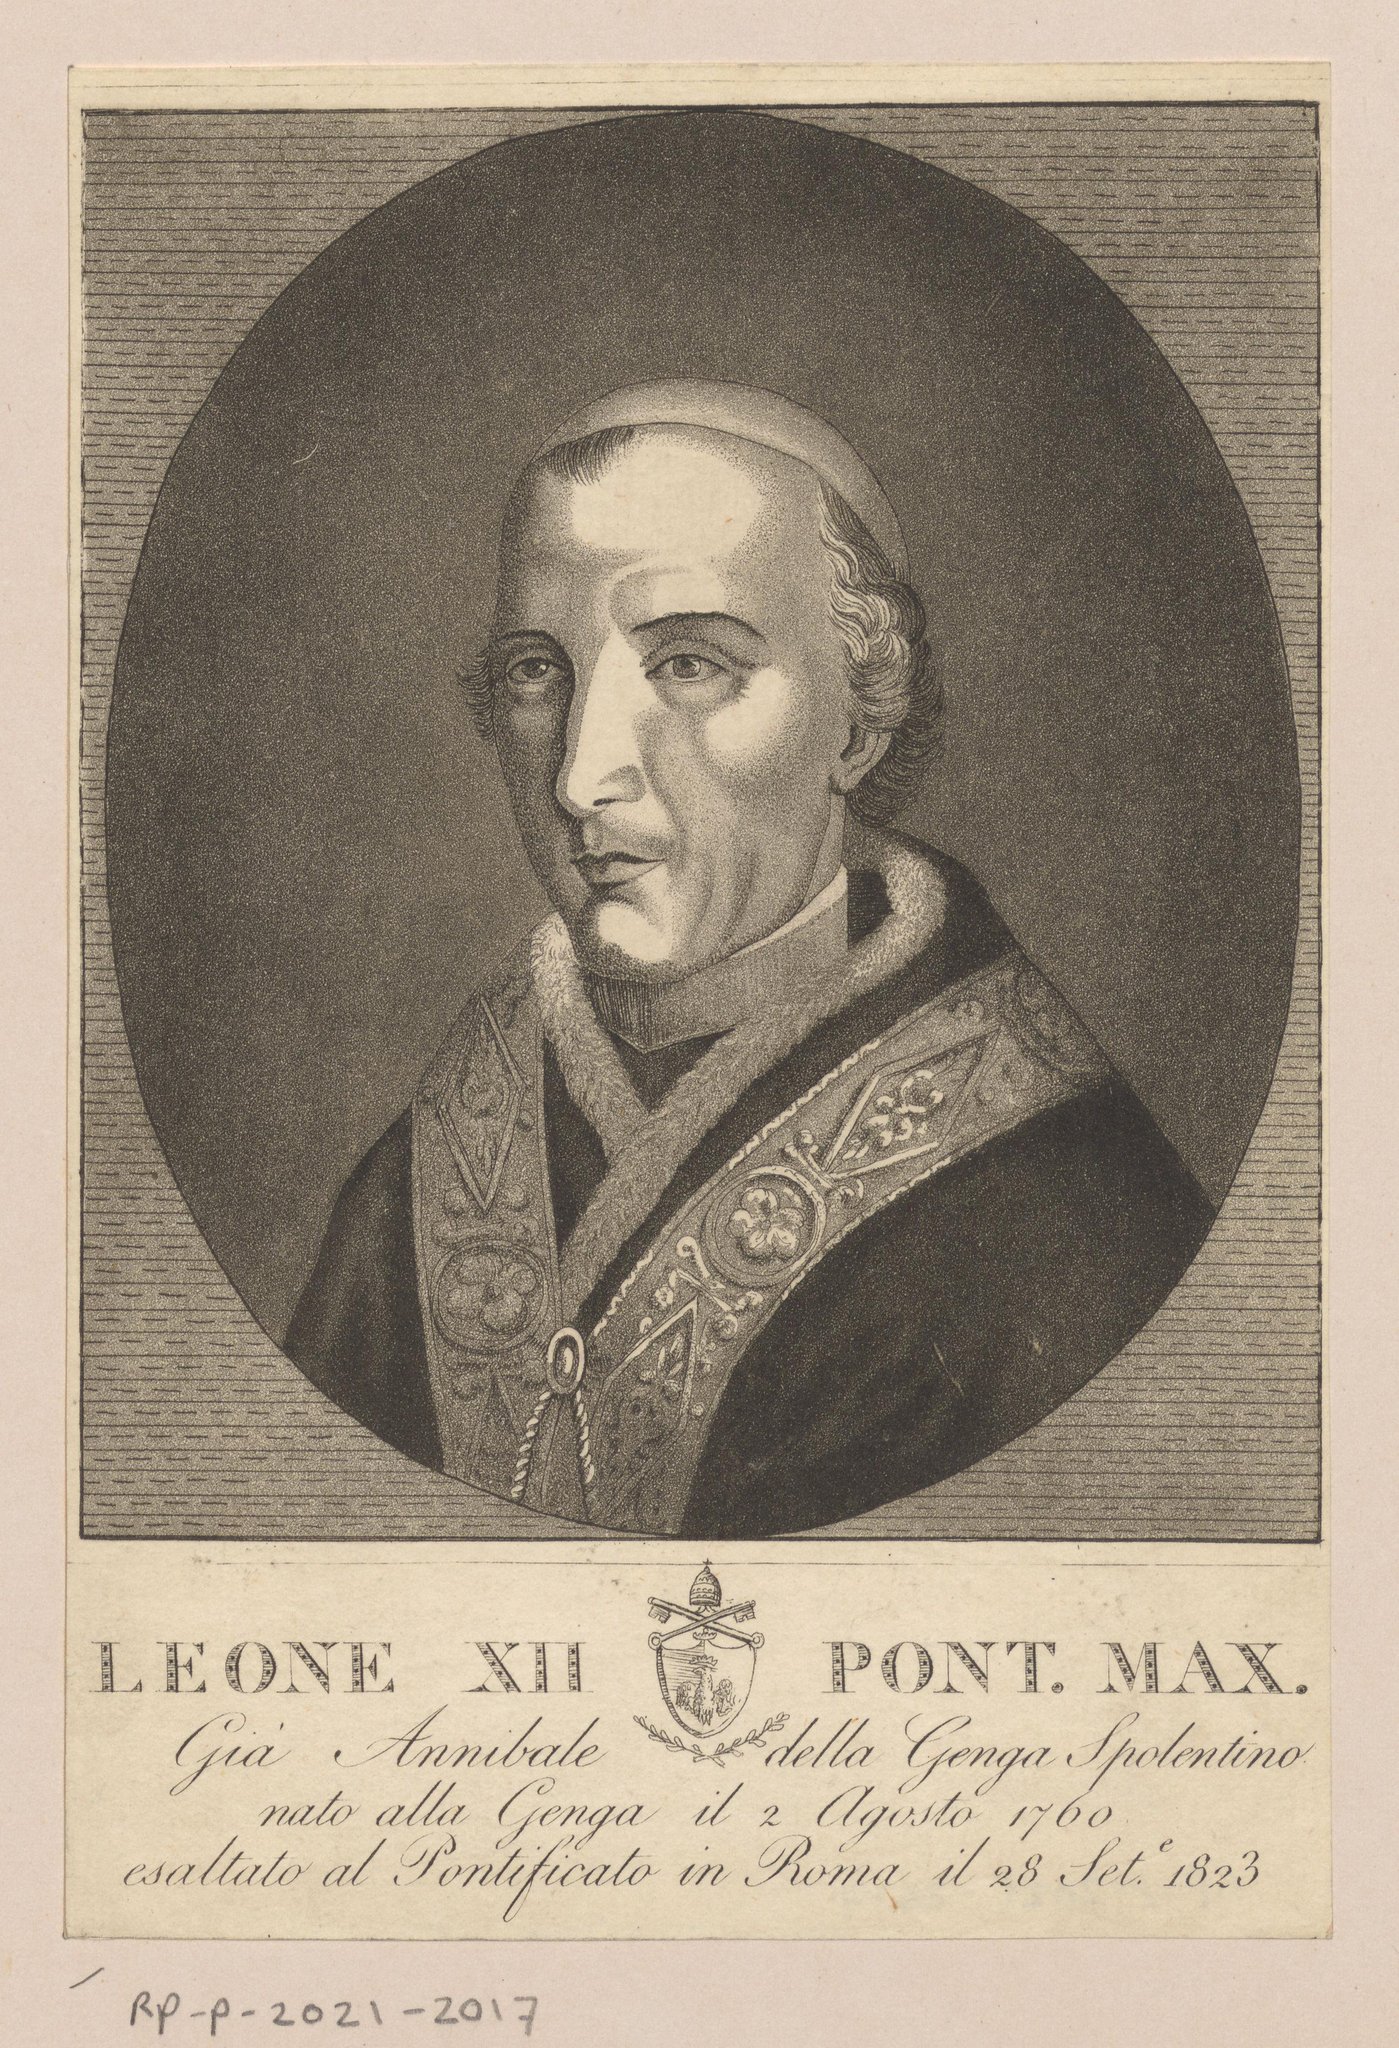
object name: print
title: Portret van paus Leo XII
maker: Anonymous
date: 1823-1850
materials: paper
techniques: aquatint, etching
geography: italy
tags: rome, historical persons, pope, armorial bearing, heraldry